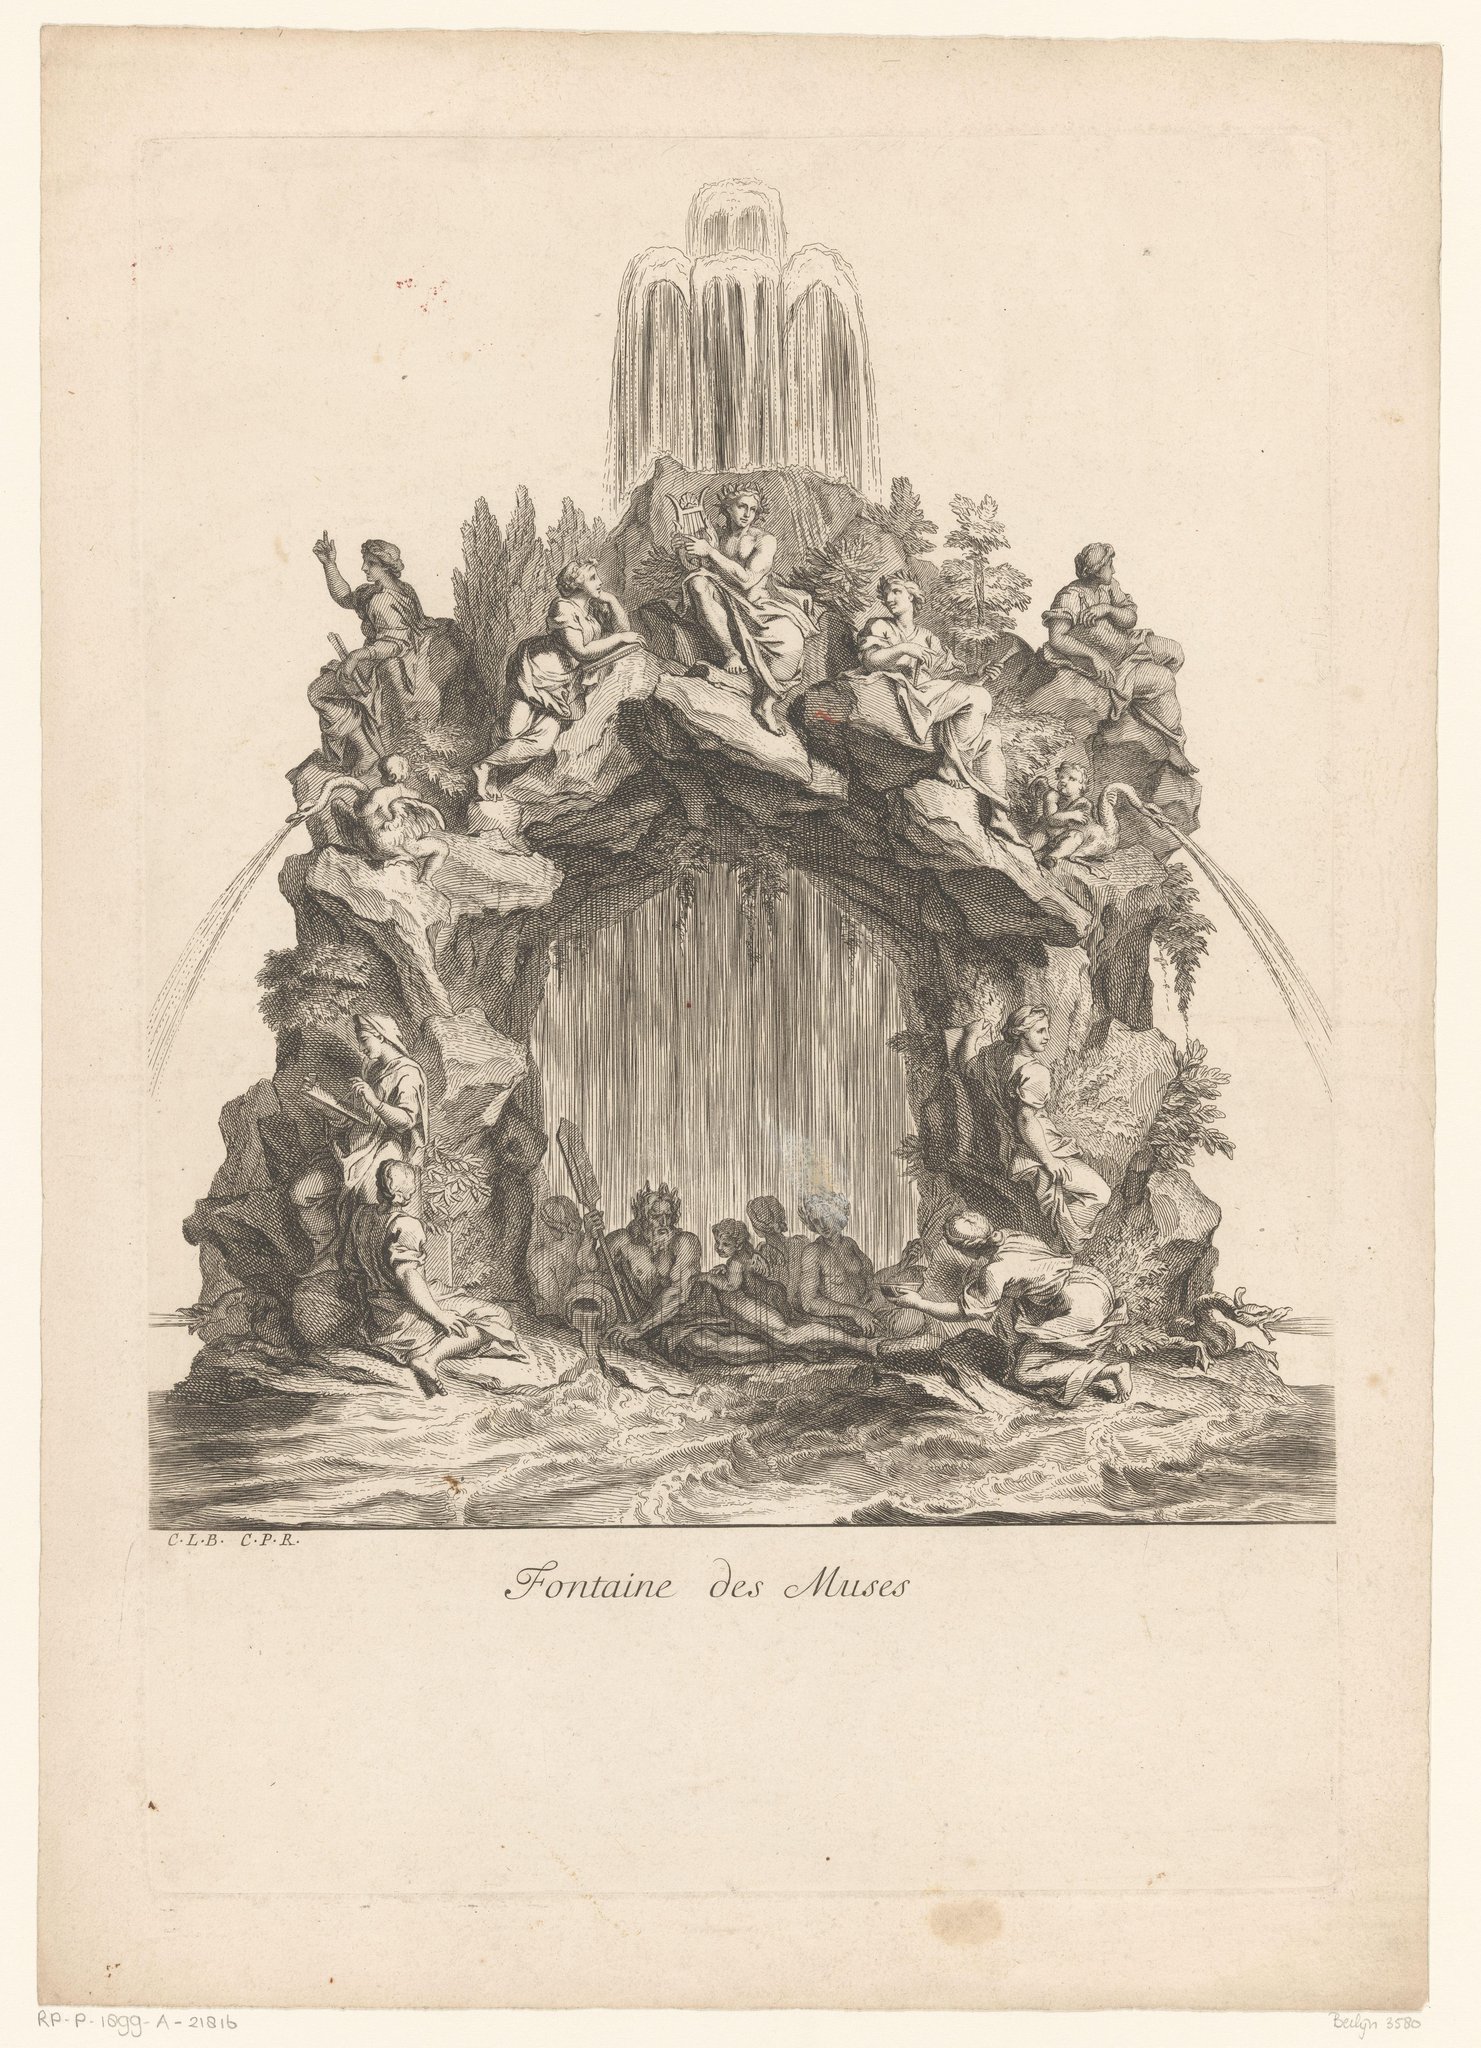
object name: ornament print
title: Fontein van de muzen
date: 1672-1686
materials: paper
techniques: etching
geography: paris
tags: apollo and the muses, apollo musagetes, ornamental fountain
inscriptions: collector's mark: Lugt 2228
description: Een fontein in de vorm van een grot met Apollo en de muzen. In de grot ligt een riviergod.